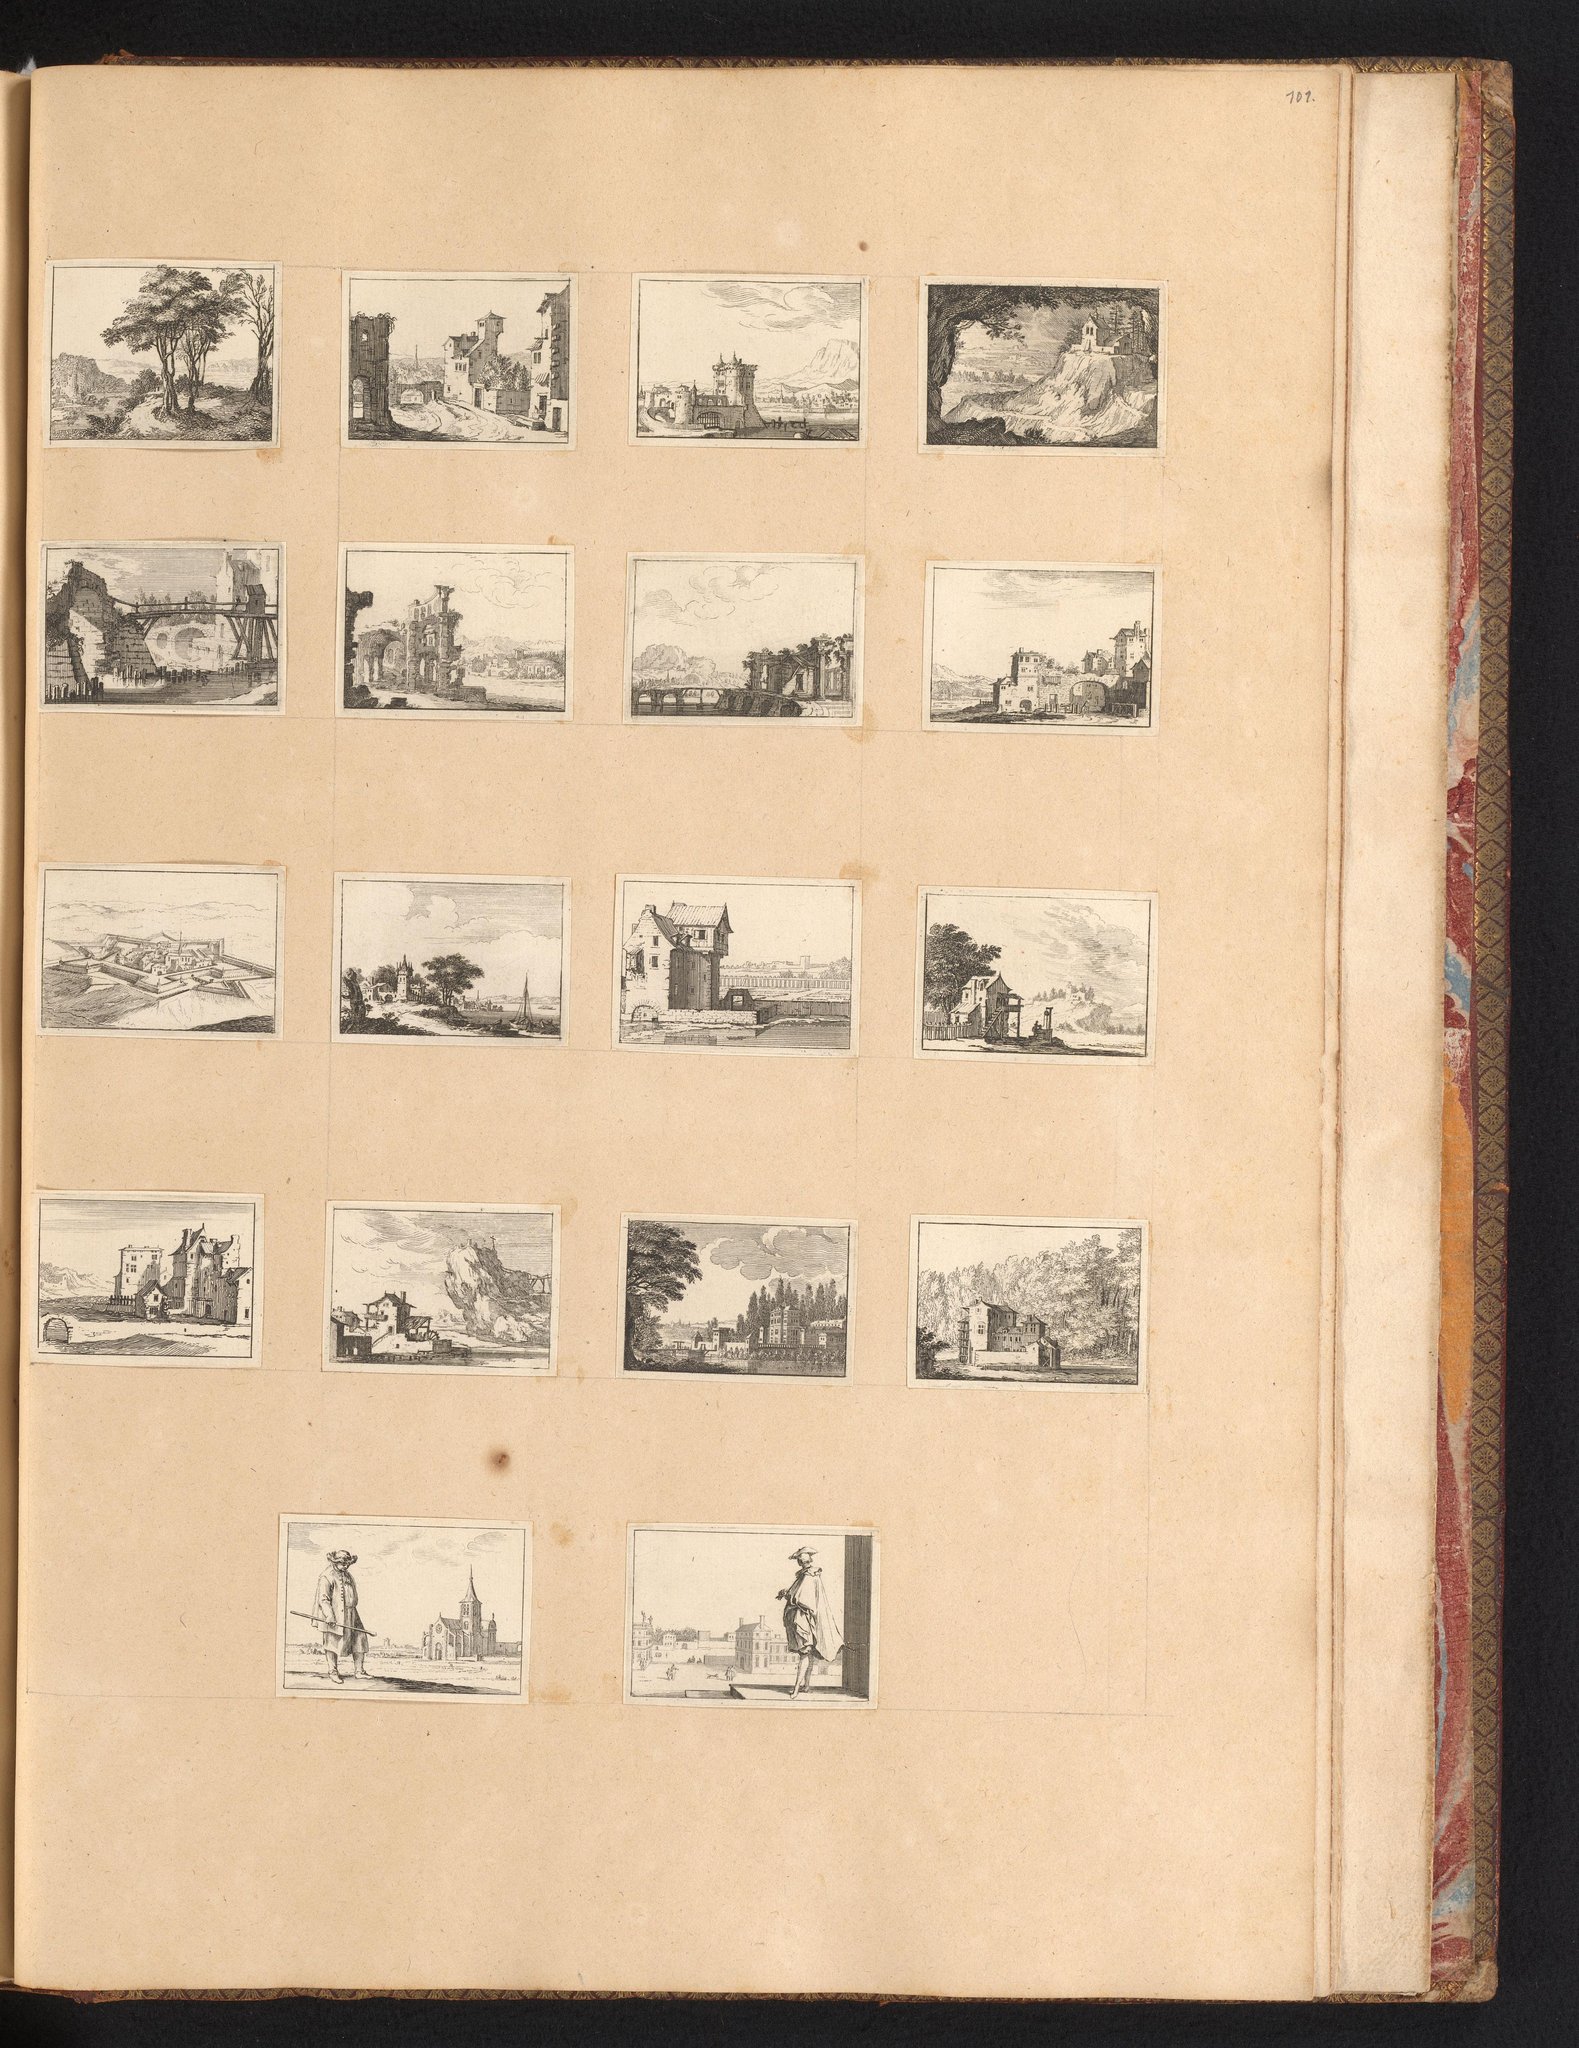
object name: album leaf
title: Landschappen en gebouwen opgedragen aan Michel François Le Tellier (markies de Courtanvaux)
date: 1683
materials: paper, pencil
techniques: etching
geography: france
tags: landscapes in the temperate zone (+ landscape with figures, staffage), civic architecture; edifices; dwellings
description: Deze prenten maken deel uit van een 37-delige serie met landschappen en bouwwerken met figuren en paarden, opgedragen aan Michel François Le Tellier (markies de Courtanvaux).